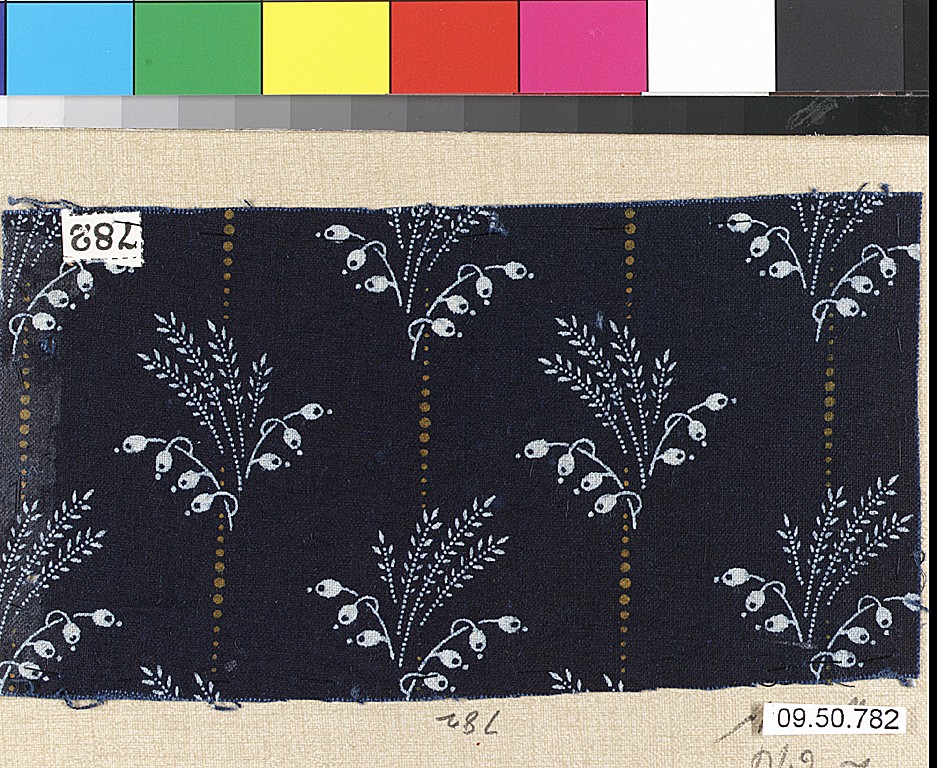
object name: piece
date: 1801-1900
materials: cotton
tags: leaves